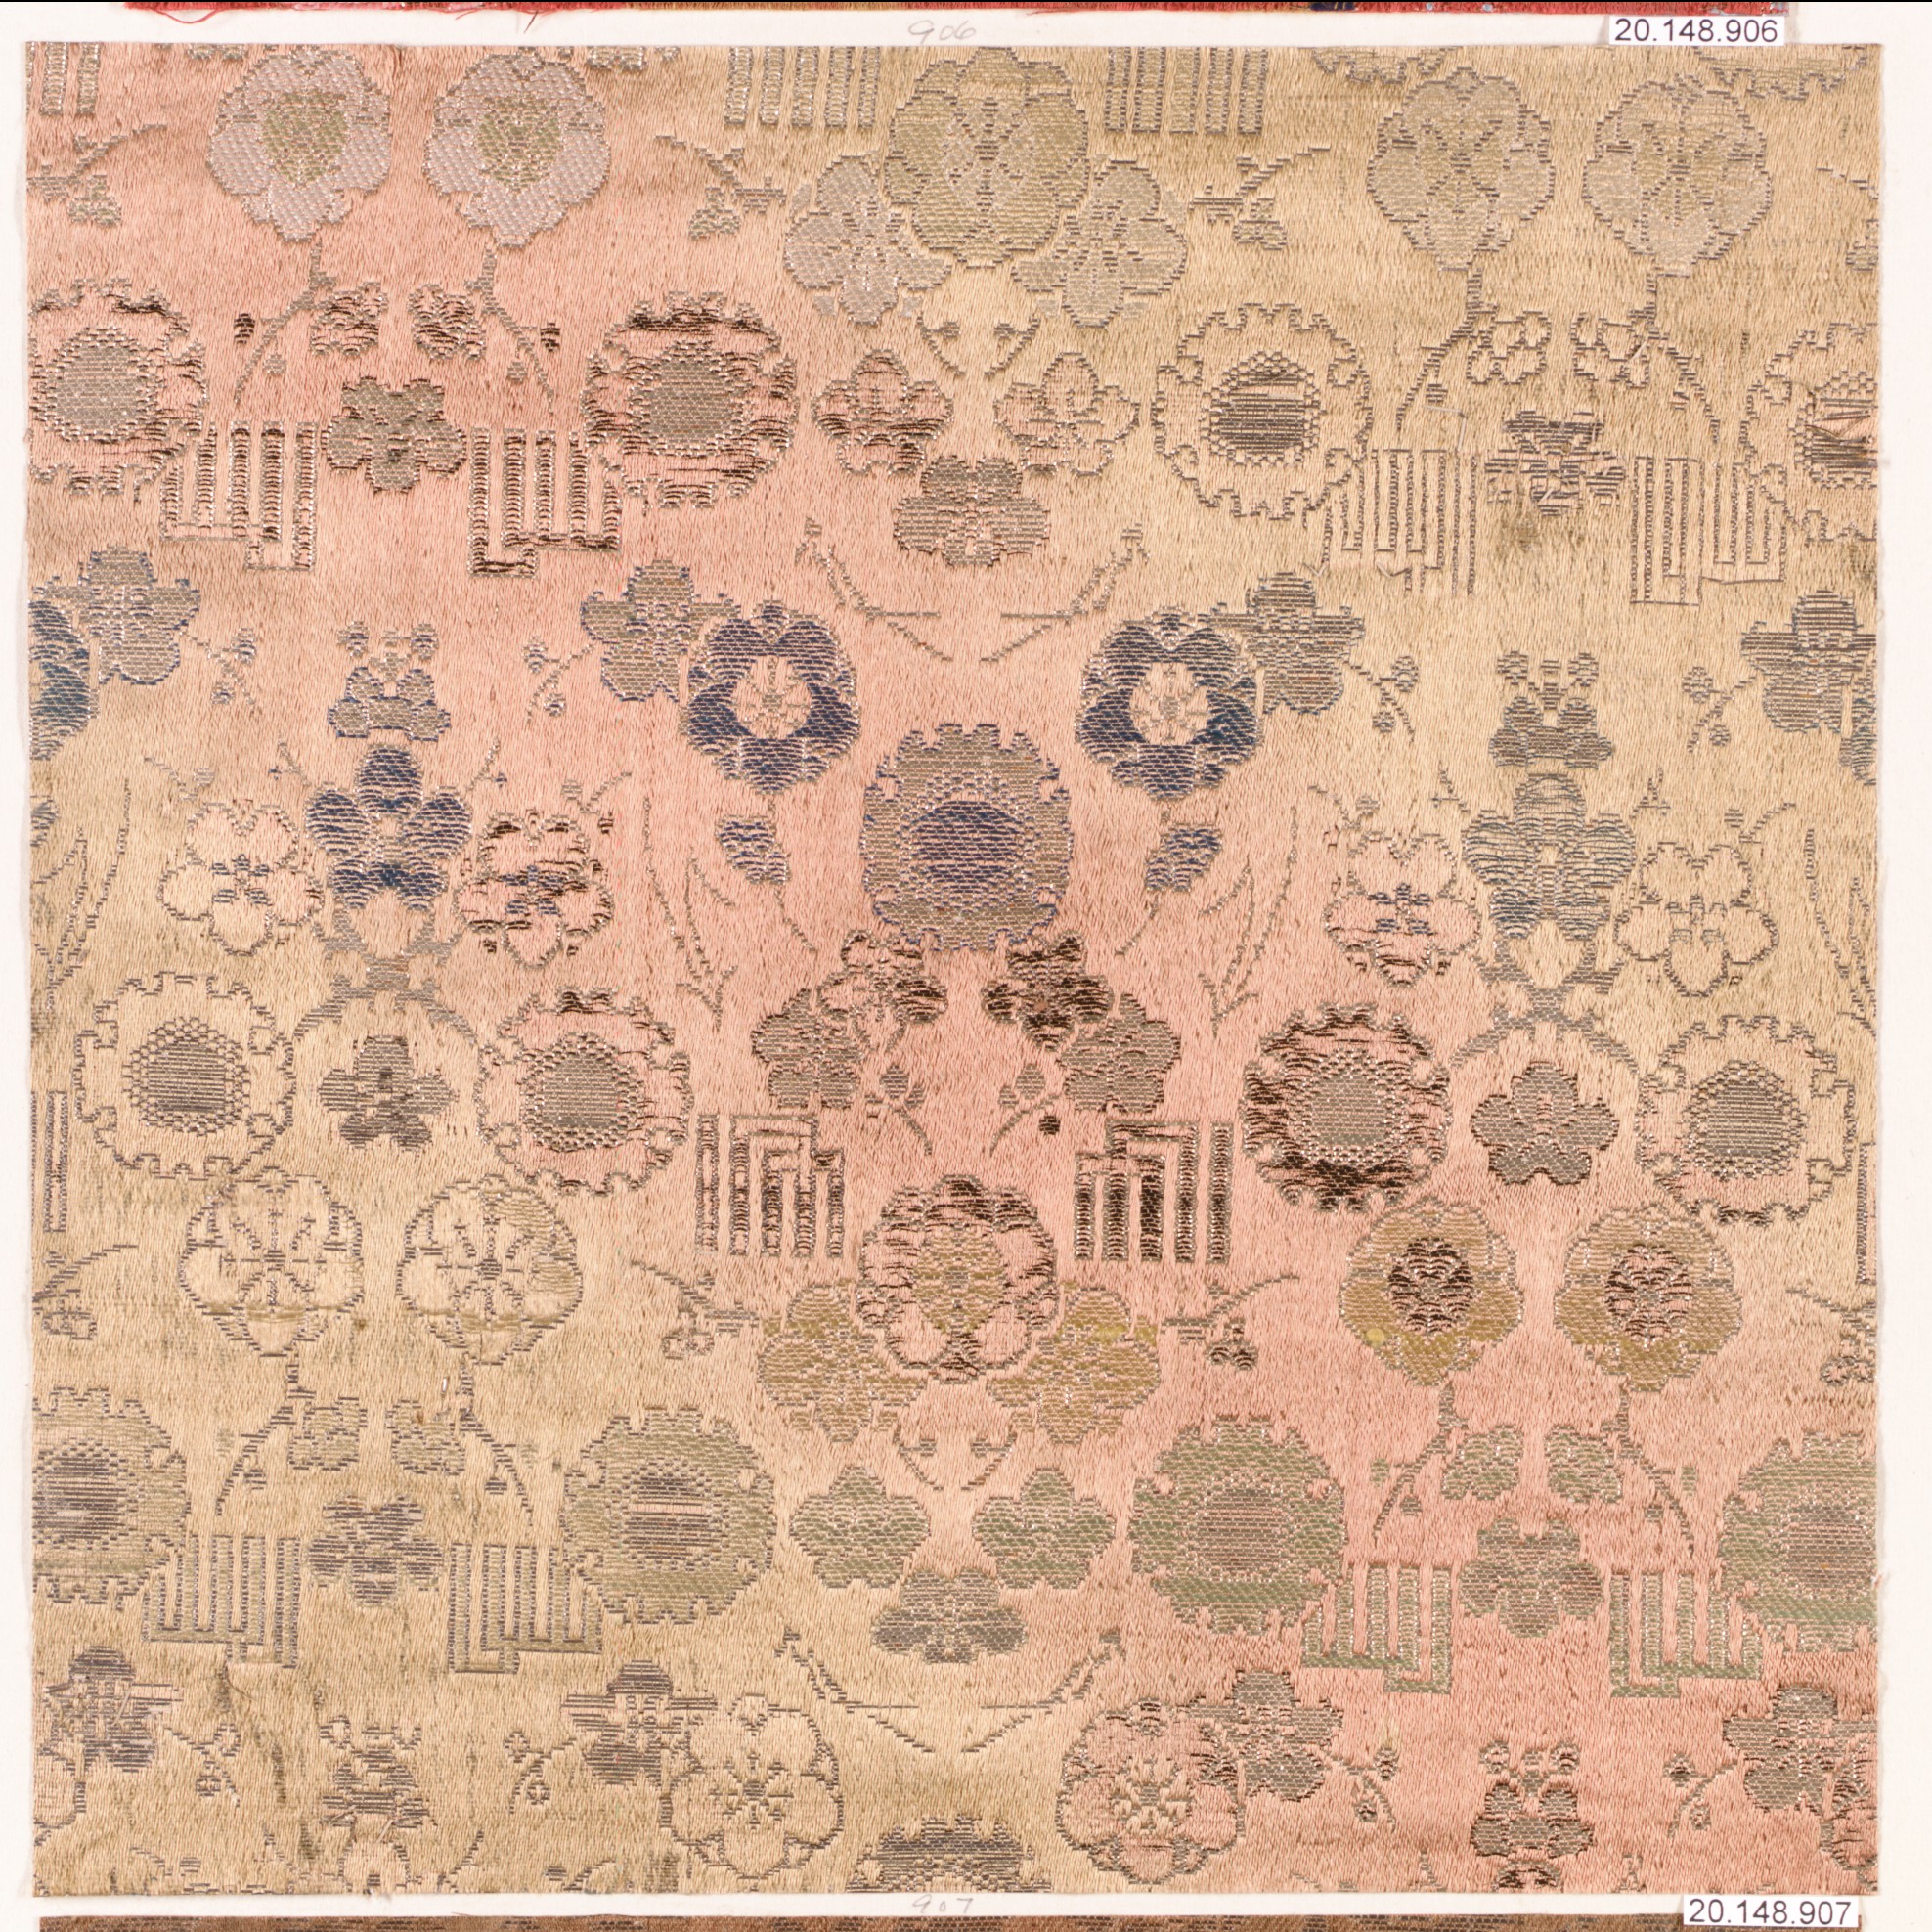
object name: piece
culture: japanese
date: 1701-1800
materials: silk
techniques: compound weave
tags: flowers